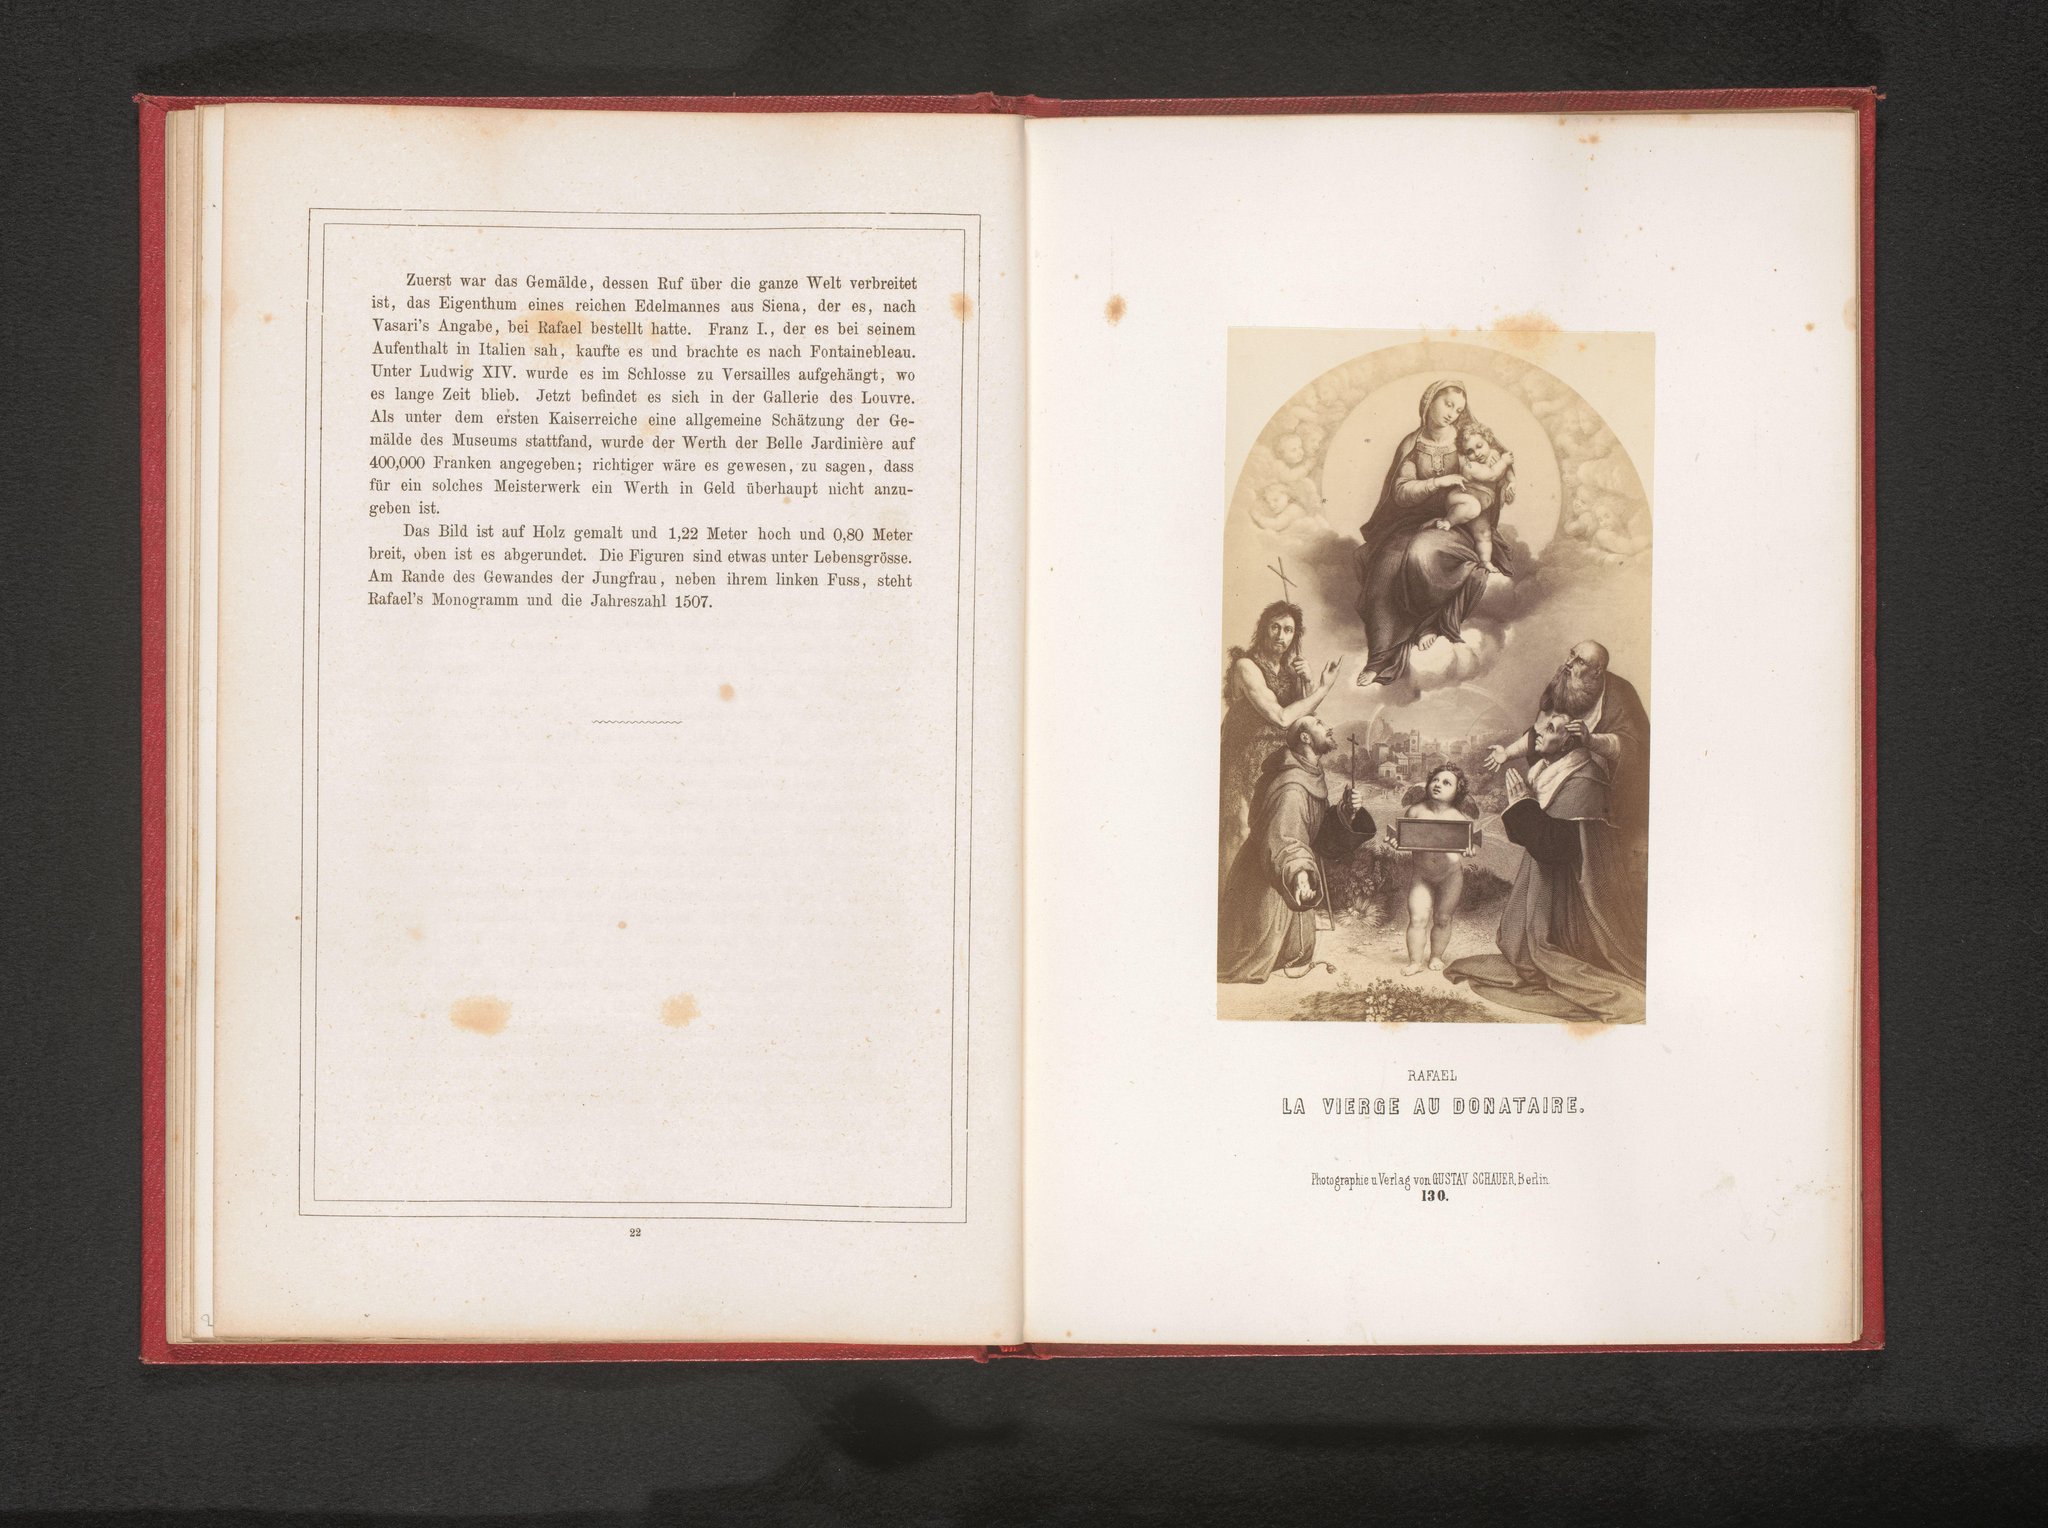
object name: page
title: Fotoreproductie van een prent naar een schilderij, voorstellende de Madonna van Foligno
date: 1856-1861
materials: photographic support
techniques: albumen print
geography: berlin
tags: madonna: i.e. mary with the christ-child (+ donor(s), supplicant(s), whether or not with patron saint(s))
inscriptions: number: ‘130.’